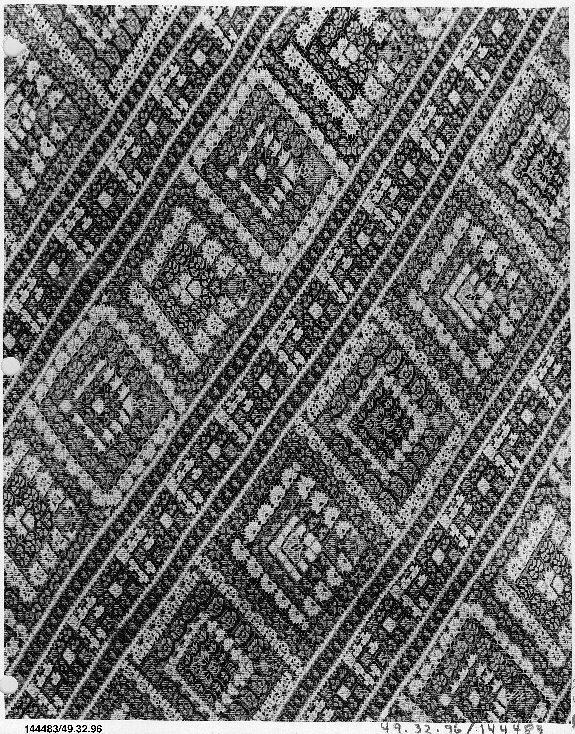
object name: trousering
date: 1701-1800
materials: linen, thread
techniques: embroidery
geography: iran